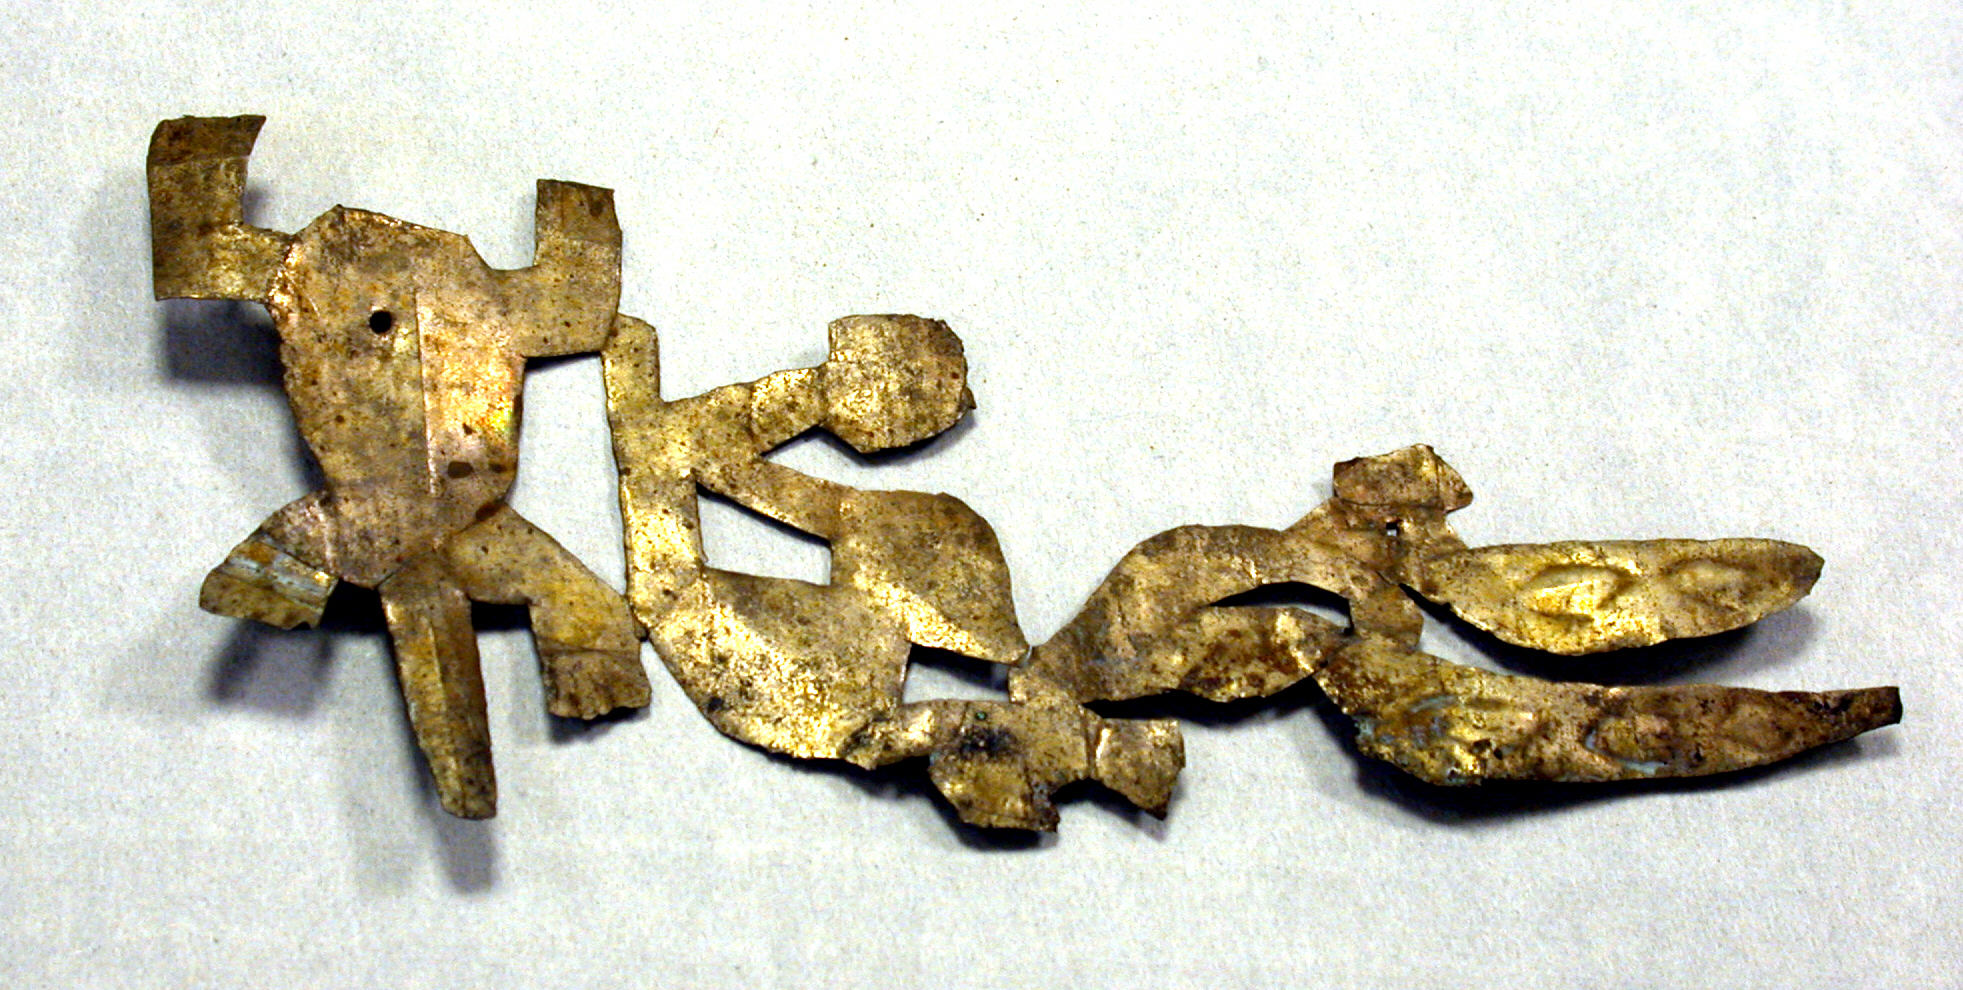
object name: ornament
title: Cut-Out Ornament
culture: peruvian, north or central coast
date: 1001-1600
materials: gilt, silver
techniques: hammering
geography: peru